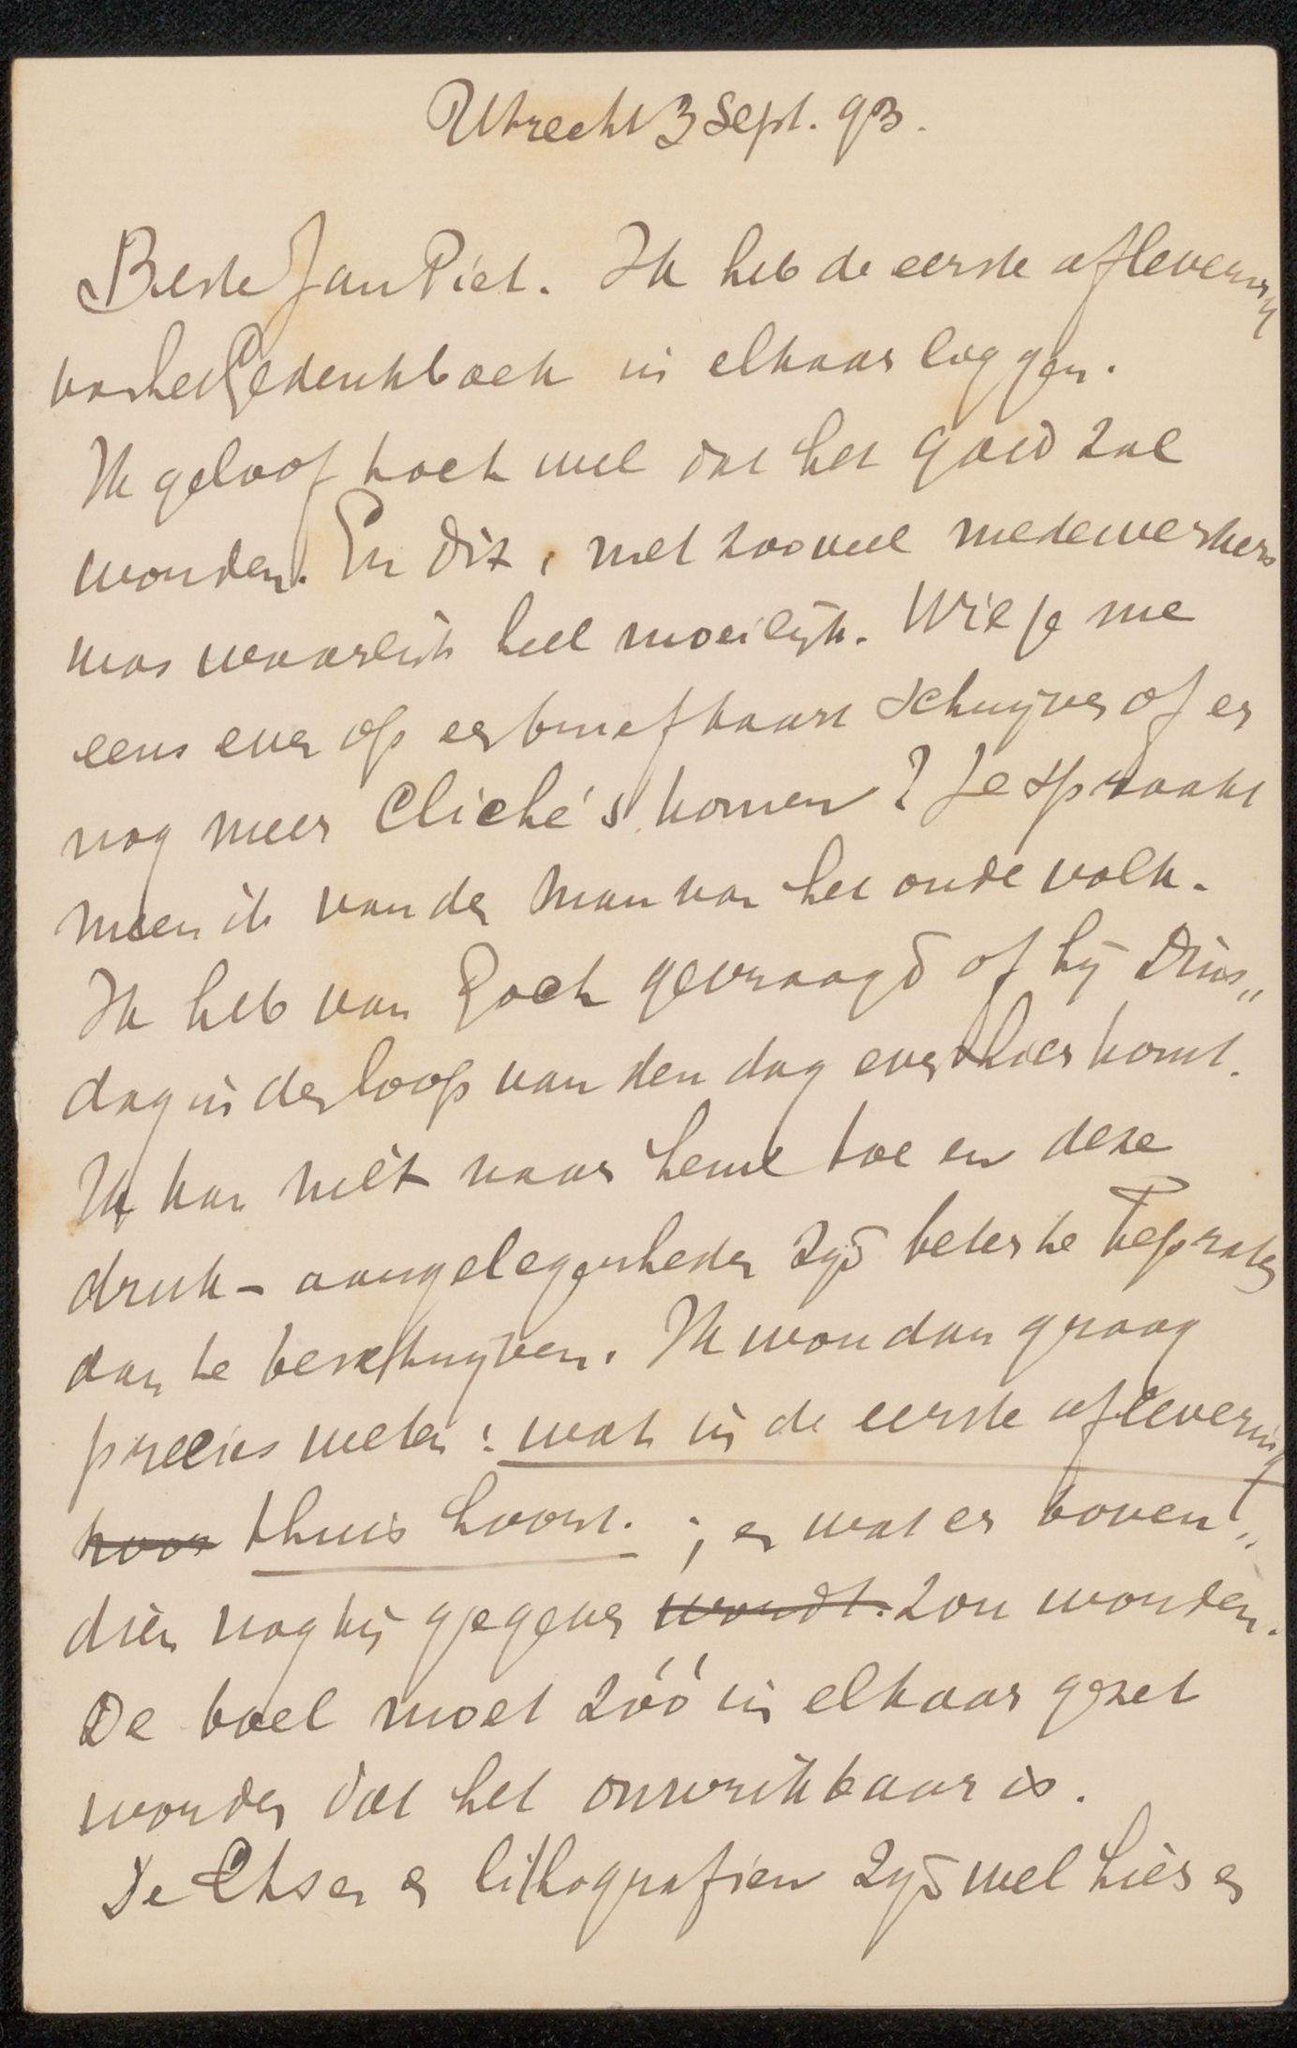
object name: letter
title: Brief aan Jan Veth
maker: antoon derkinderen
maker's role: draughtsman, painter, print maker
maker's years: 1859-1925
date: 1893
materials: ink, paper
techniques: pen, writing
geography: utrecht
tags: dordrecht, amsterdam, painter, print maker, draughtsman, designer, jan veth, alphons diepenbrock, johan frederik ankersmit, photography, cinematography, the graphic arts, printed matter, cologne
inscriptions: collector's mark: ‘RPK’